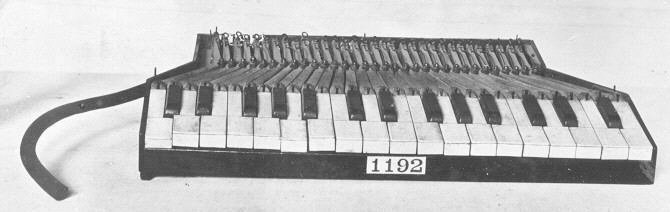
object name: hamoniphon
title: Harmoniphon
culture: french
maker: paris, lecrosnier & tremblai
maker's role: maker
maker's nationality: french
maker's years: 1820-1870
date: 1836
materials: metal, wood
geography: france